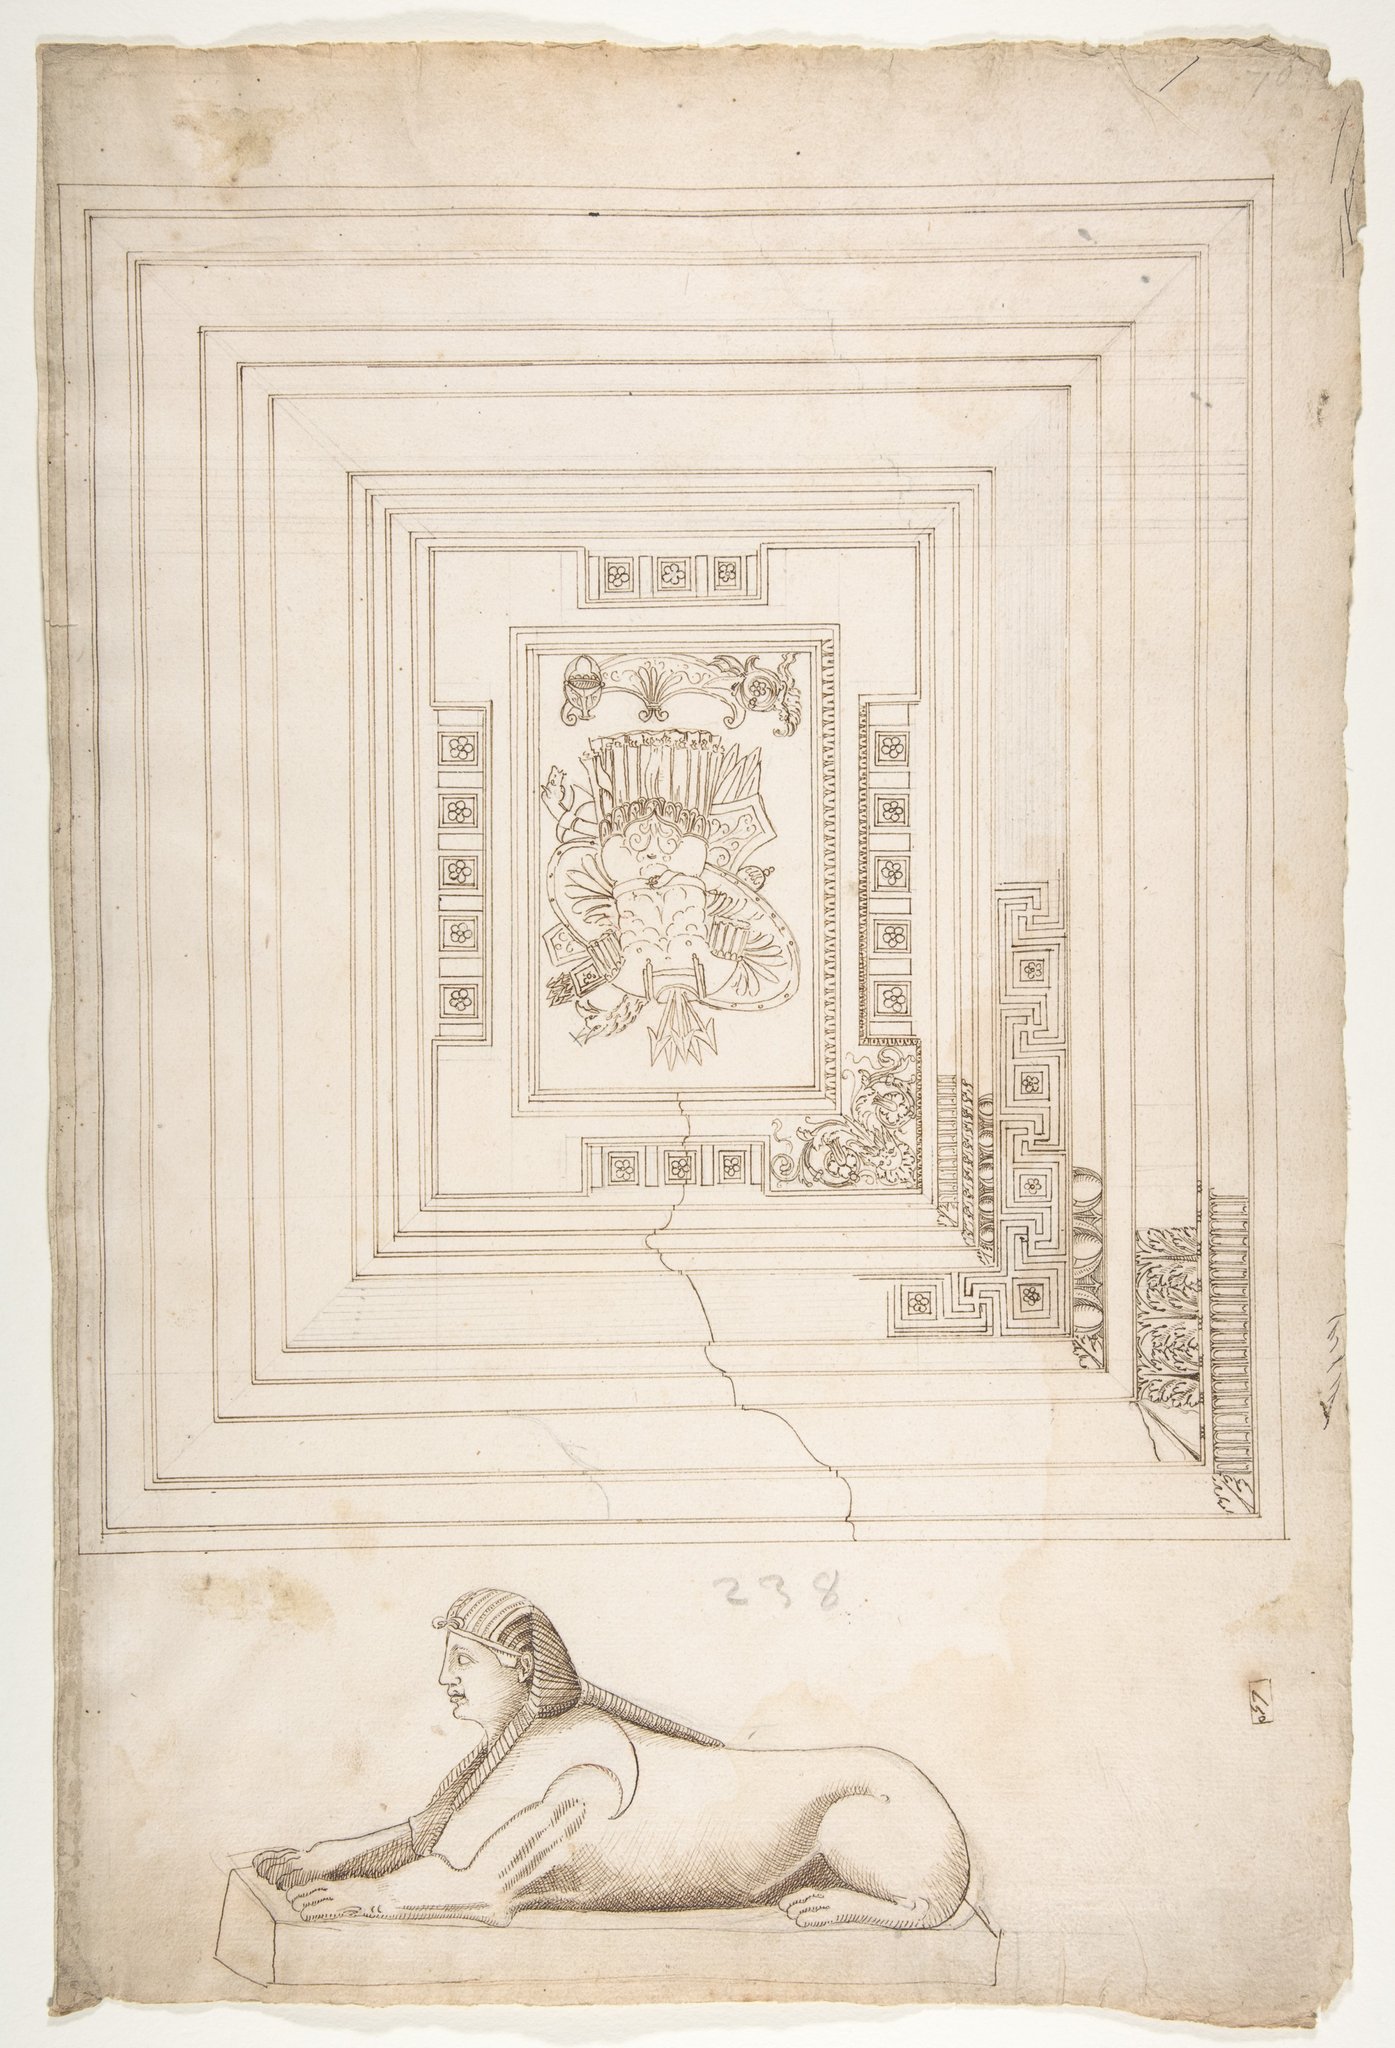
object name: drawing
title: Palazzo dei Conservatori, coffered ceiling, ceiling plan and details; Sphinx, perspective view (recto) blank (verso)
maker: anonymous, french, 16th century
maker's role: draftsman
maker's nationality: french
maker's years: 1500-1600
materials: chalk, ink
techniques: incising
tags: sphinx